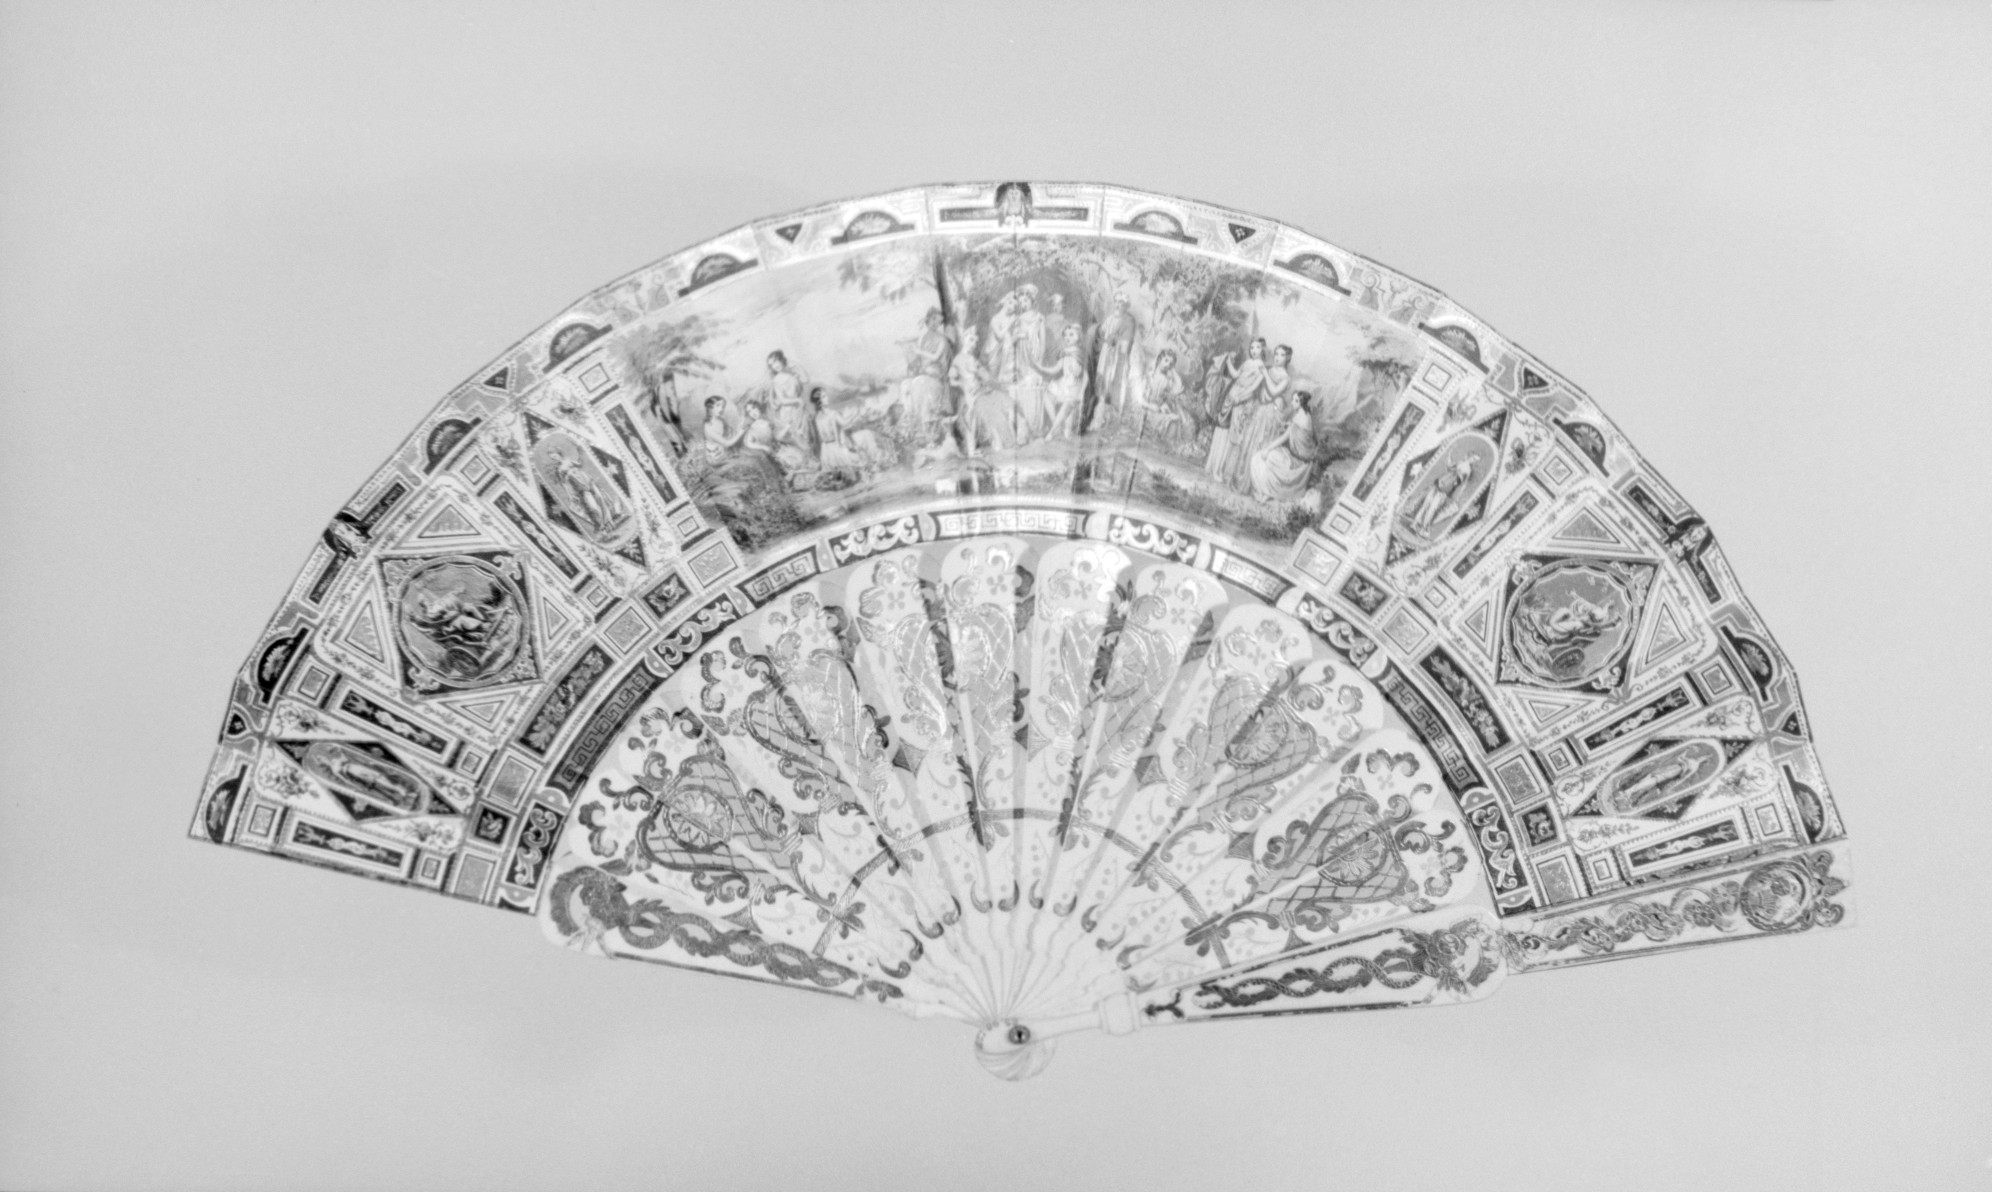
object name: fan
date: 1834-1866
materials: gilt, glass, ivory, paint, paper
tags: men,women,dogs